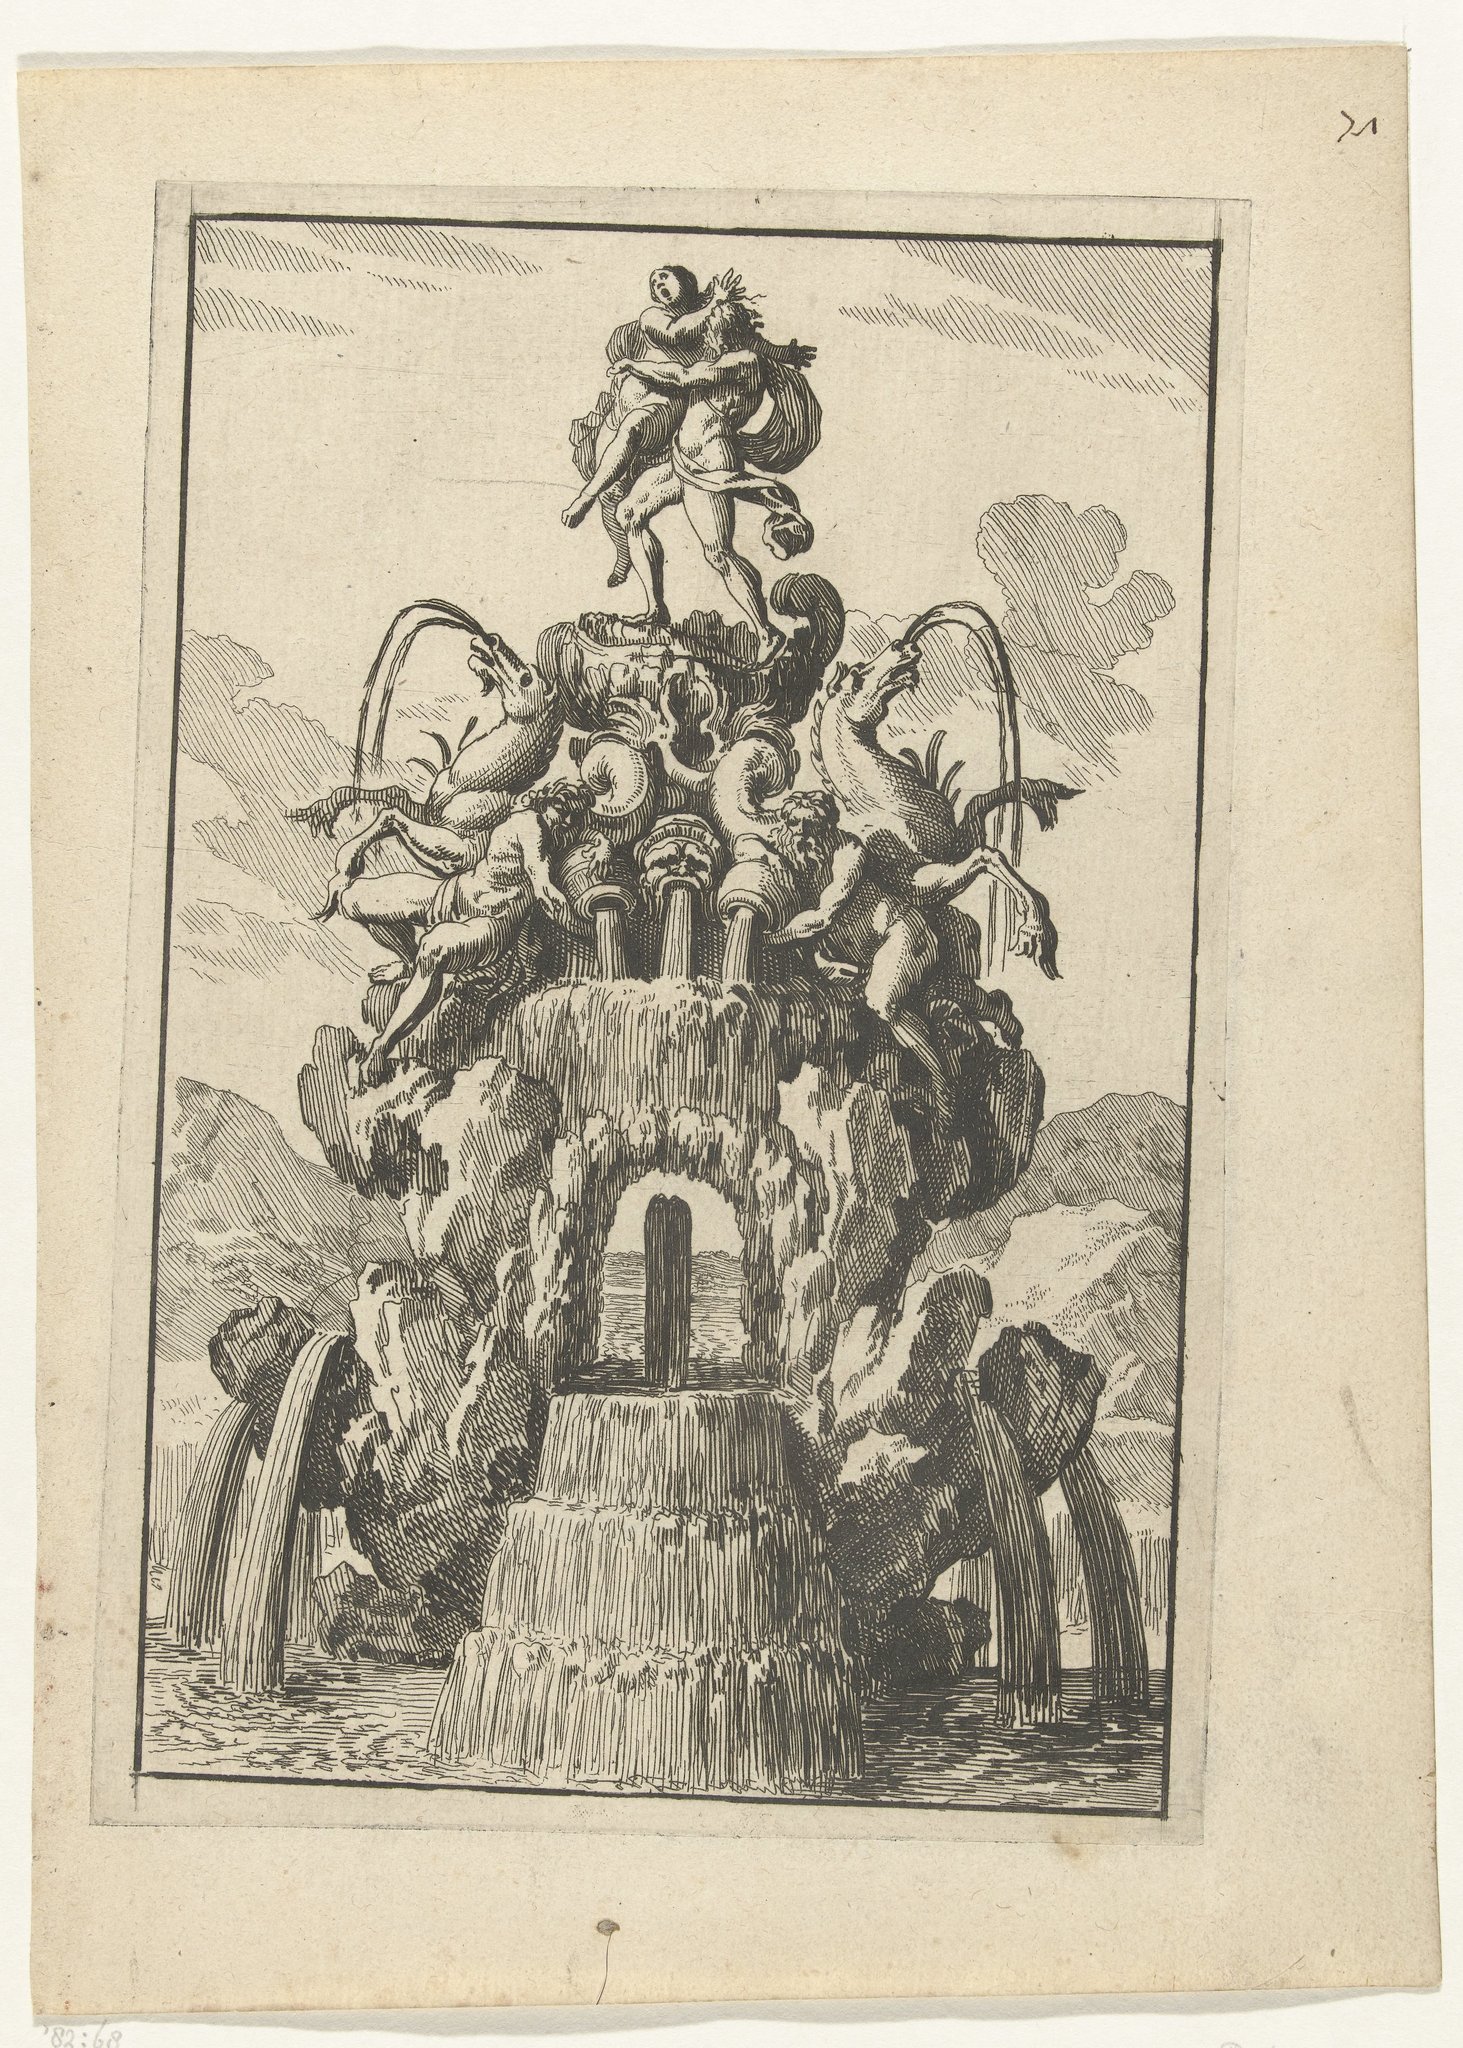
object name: ornament print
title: Fontein met twee etages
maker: jean lepautre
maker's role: draughtsman, print maker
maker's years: 1618-1682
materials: paper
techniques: etching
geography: paris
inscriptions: number: ‘72’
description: De fontein is opgebouwd uit rotsen en rocailles, bovenop ontvoert een man een vrouw. Uit serie van 6 ongenummerde bladen.